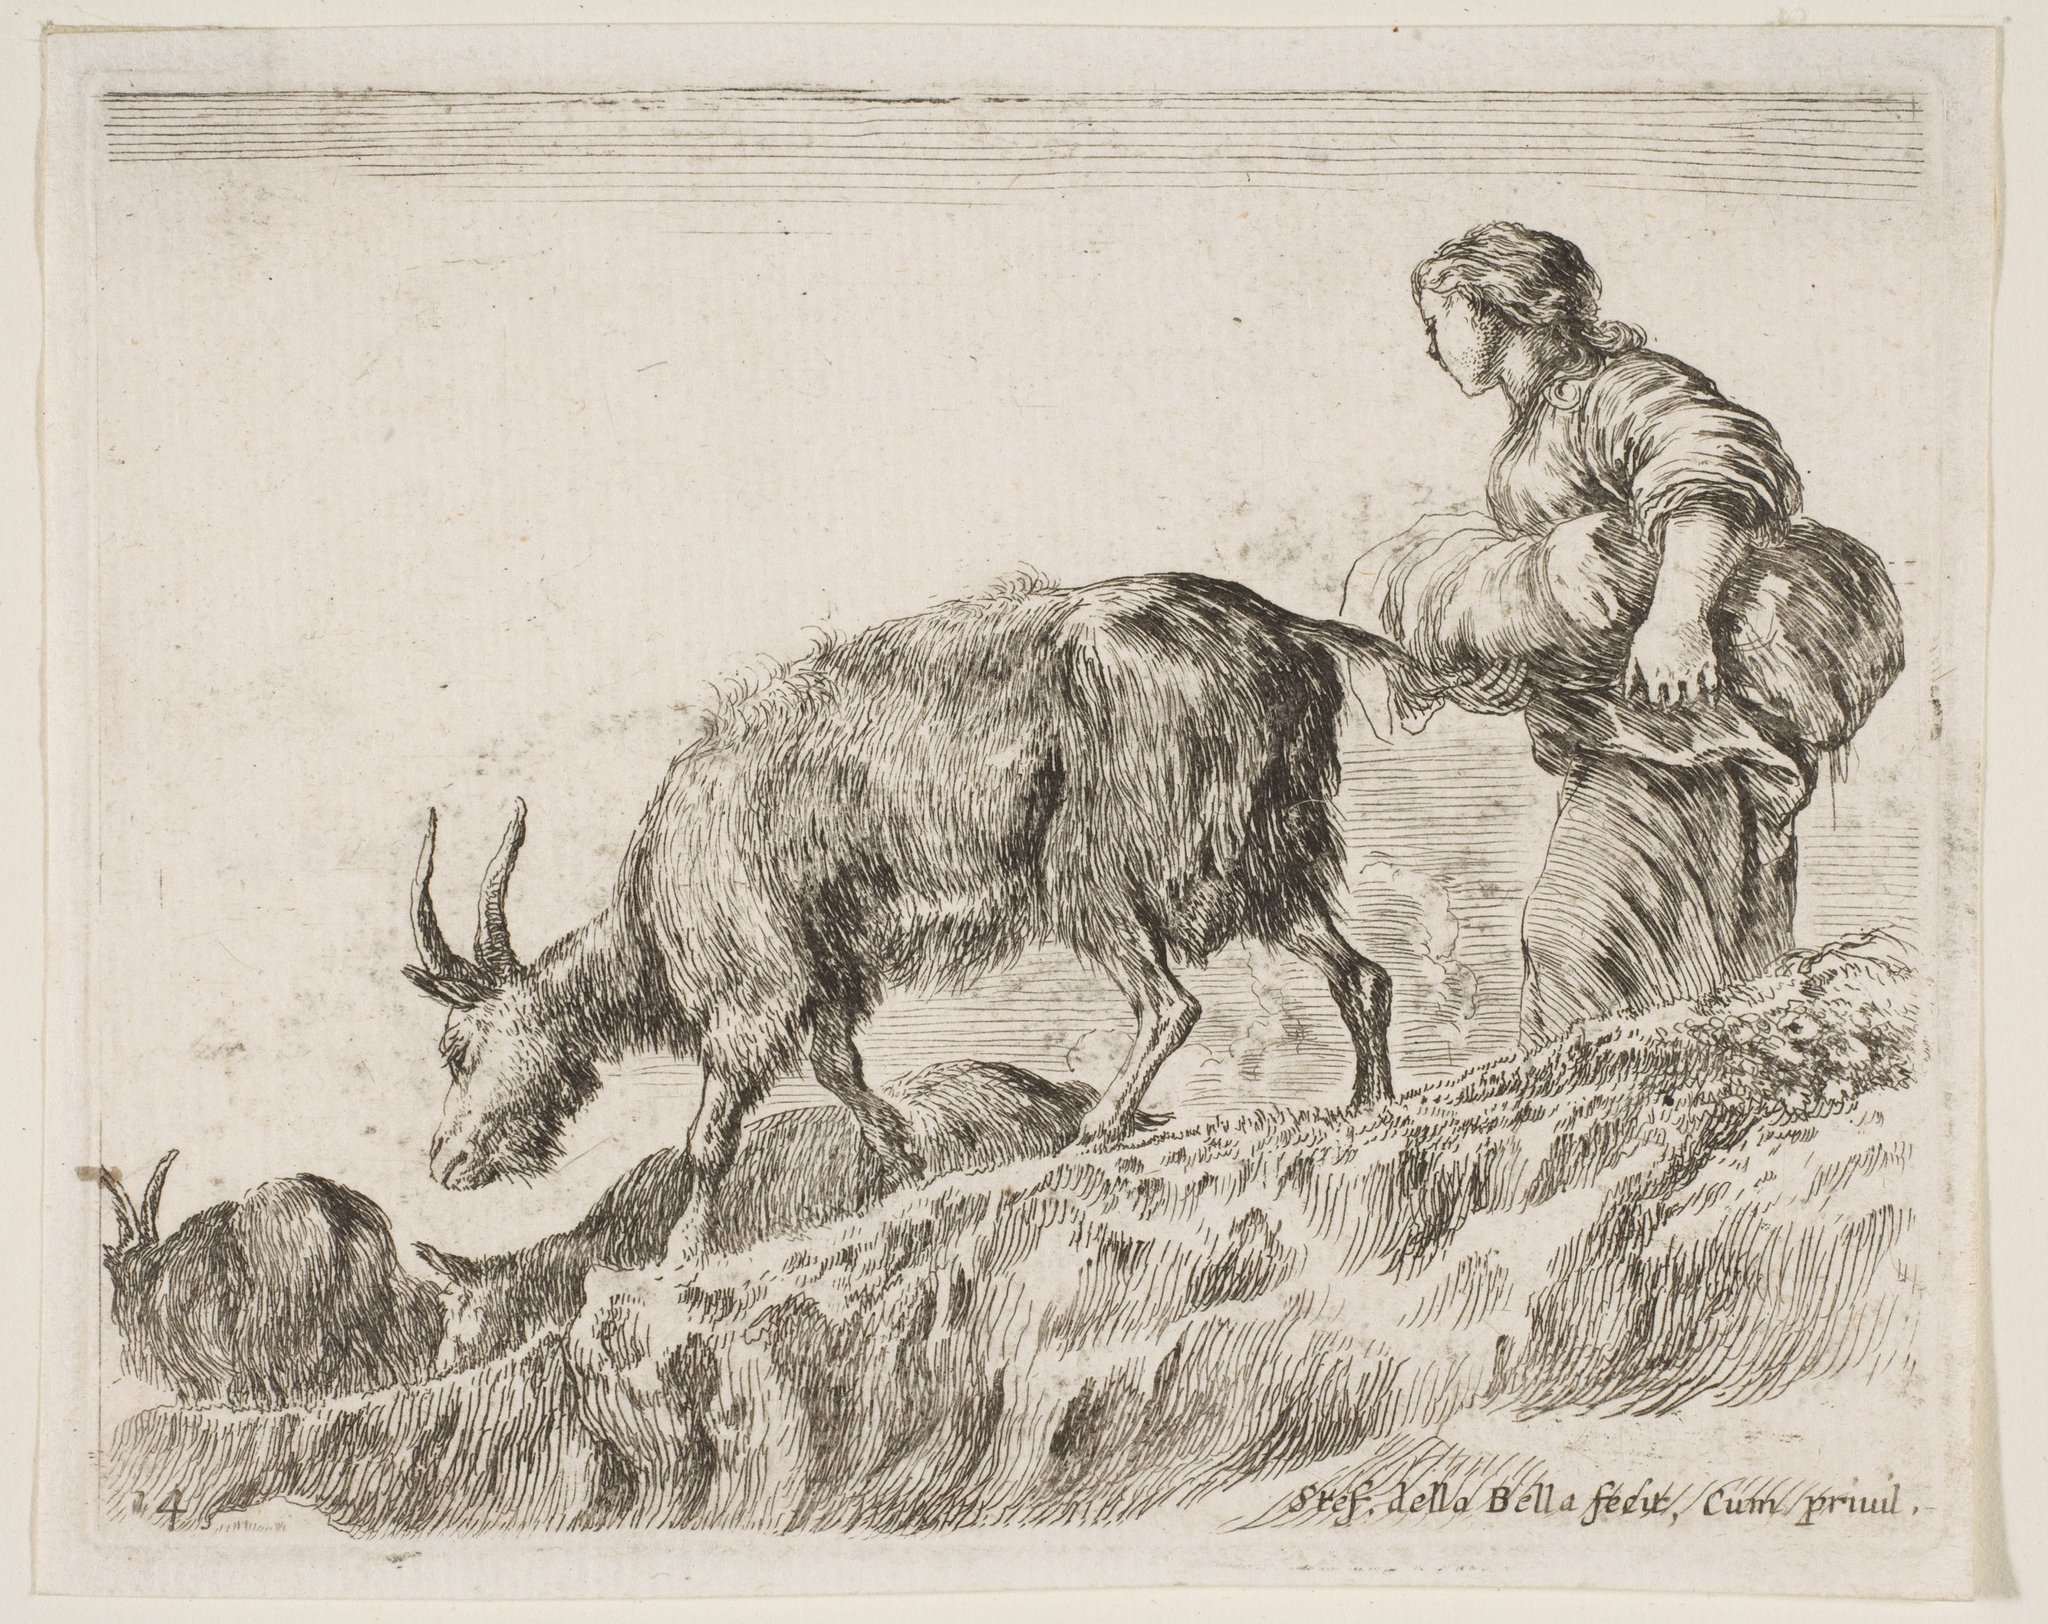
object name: print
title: Shepherdess herding goats, plate 14 from "Various Animals" (Diversi Animali)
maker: stefano della bella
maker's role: artist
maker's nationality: italian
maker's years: 1610-1664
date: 1641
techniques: etching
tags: women,goats,shepherds